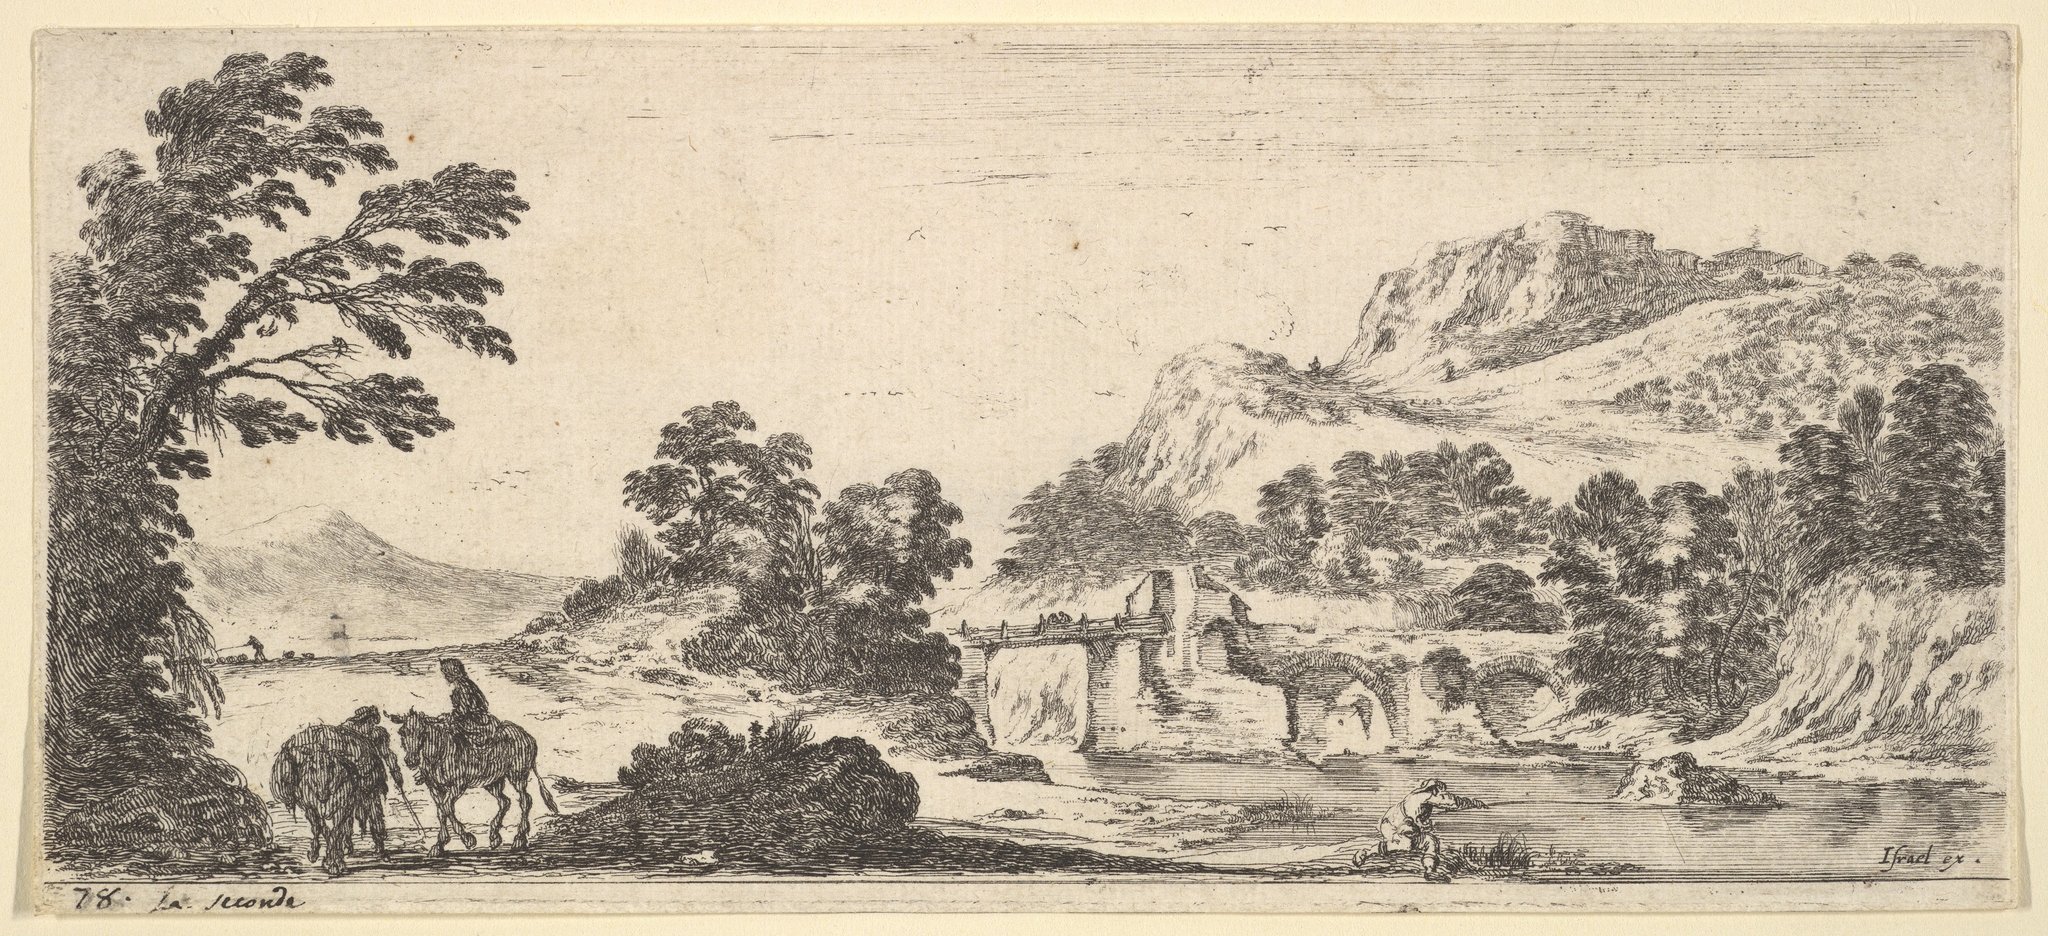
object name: print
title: A mule carrying a woman and a peasant walking with a mule to left, a fisherman to right casting his line towards the right, a bridge in the center background, from "Various Landscapes" (Divers Paysages)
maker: stefano della bella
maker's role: artist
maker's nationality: italian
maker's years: 1610-1664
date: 1641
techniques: etching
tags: animals,bridges,fishing,landscapes,trees